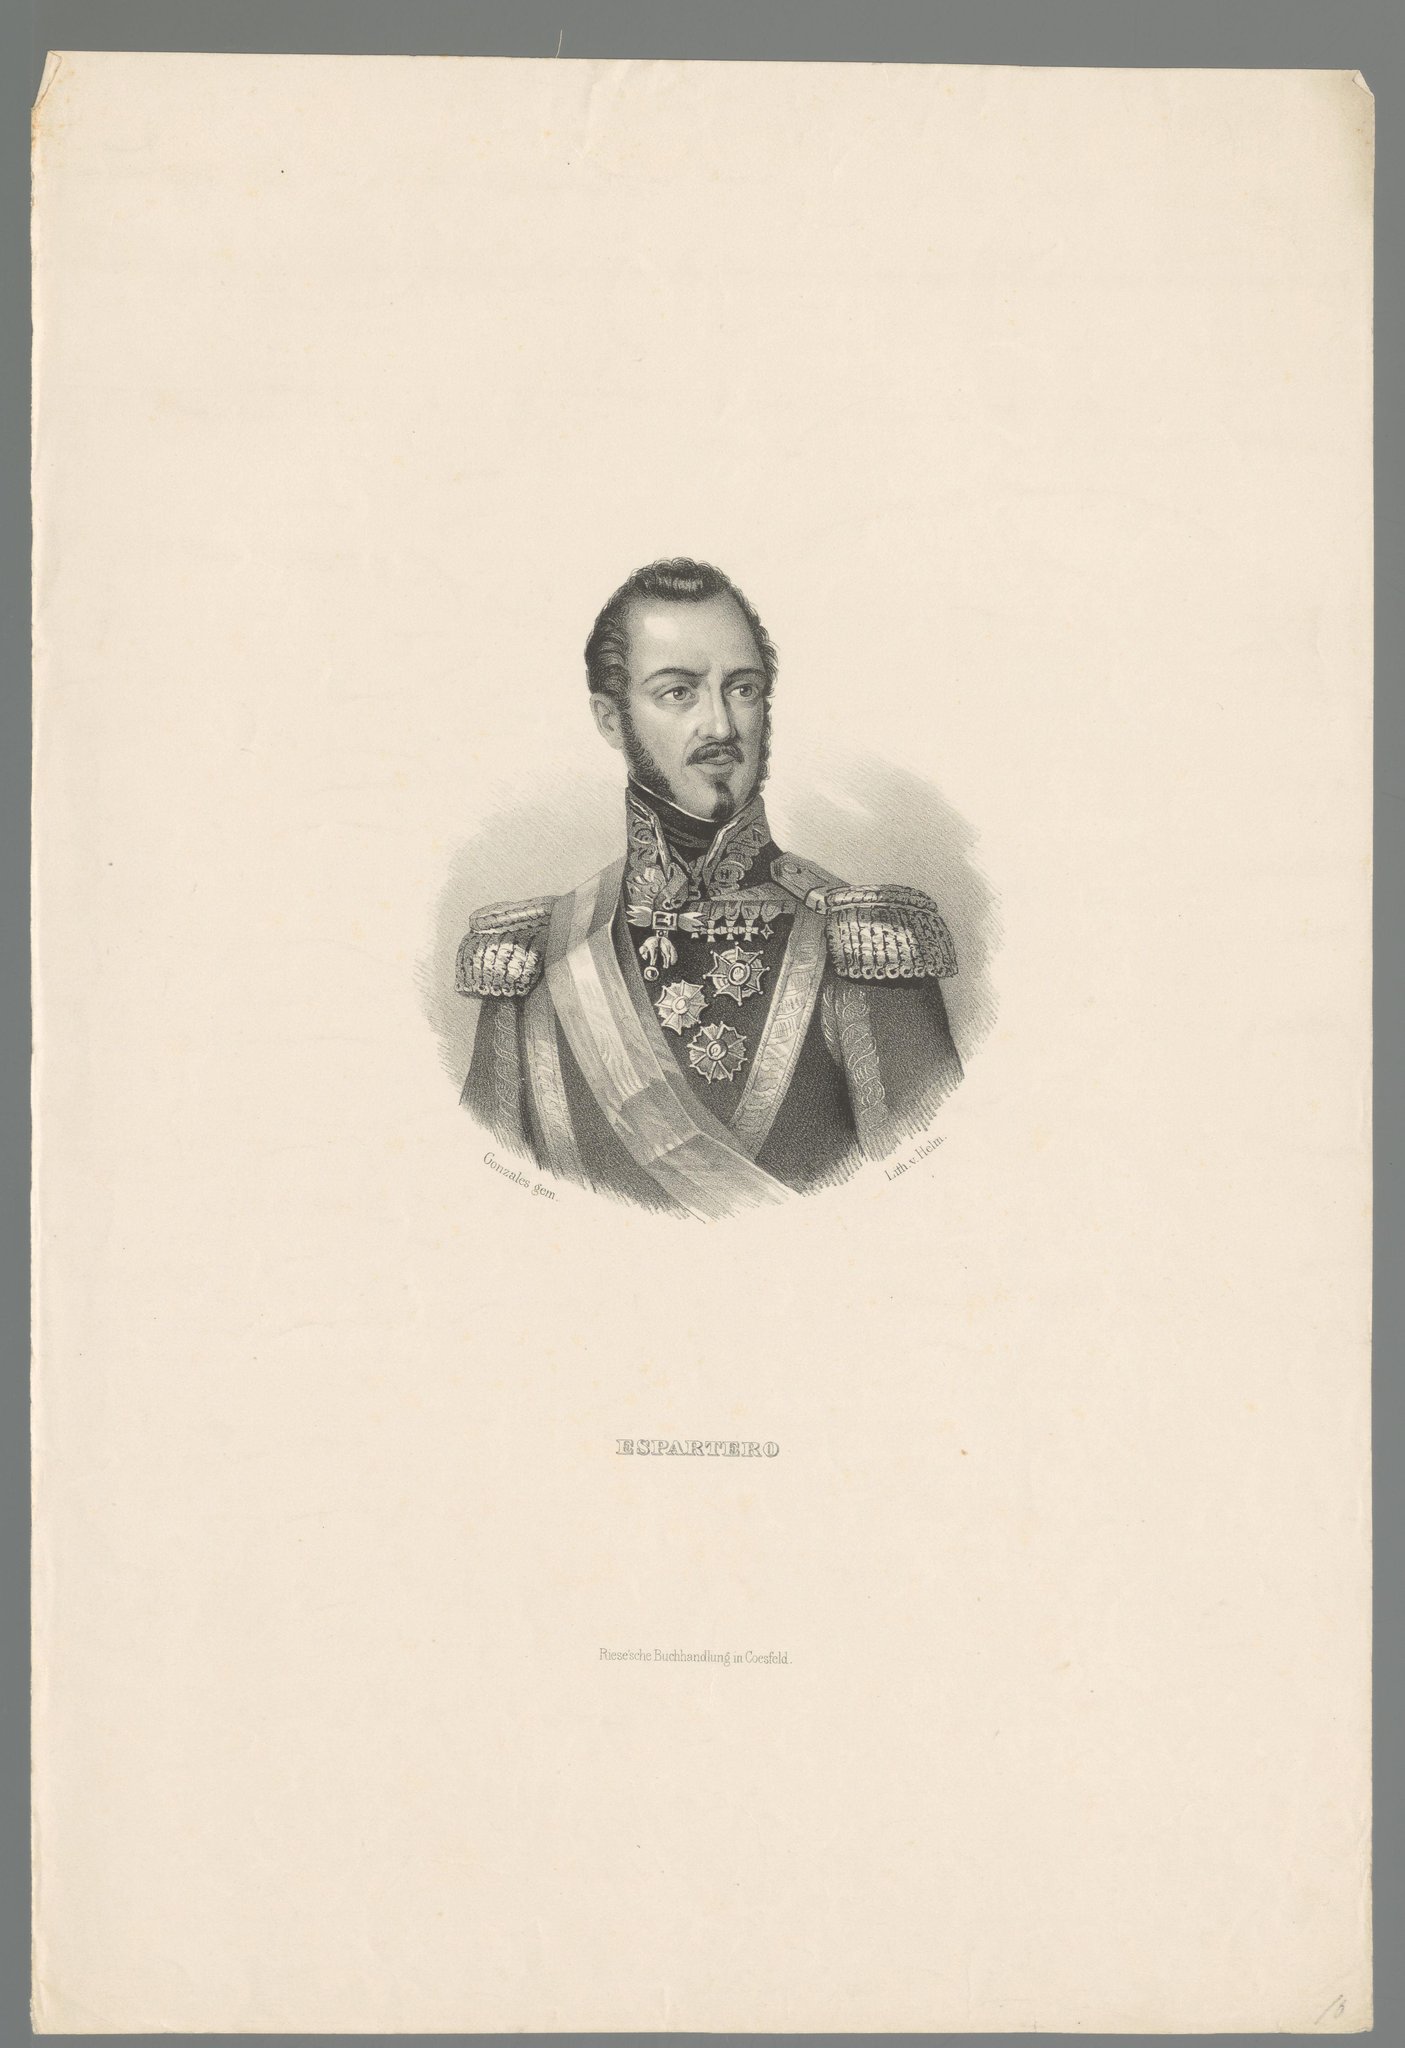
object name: print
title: Espartero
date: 1820-1880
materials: paper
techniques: lithograph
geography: coesfeld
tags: politician, commander-in-chief, general, marshal, historical persons, politician, e.g. party leader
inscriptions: collector's mark: Lugt 2228